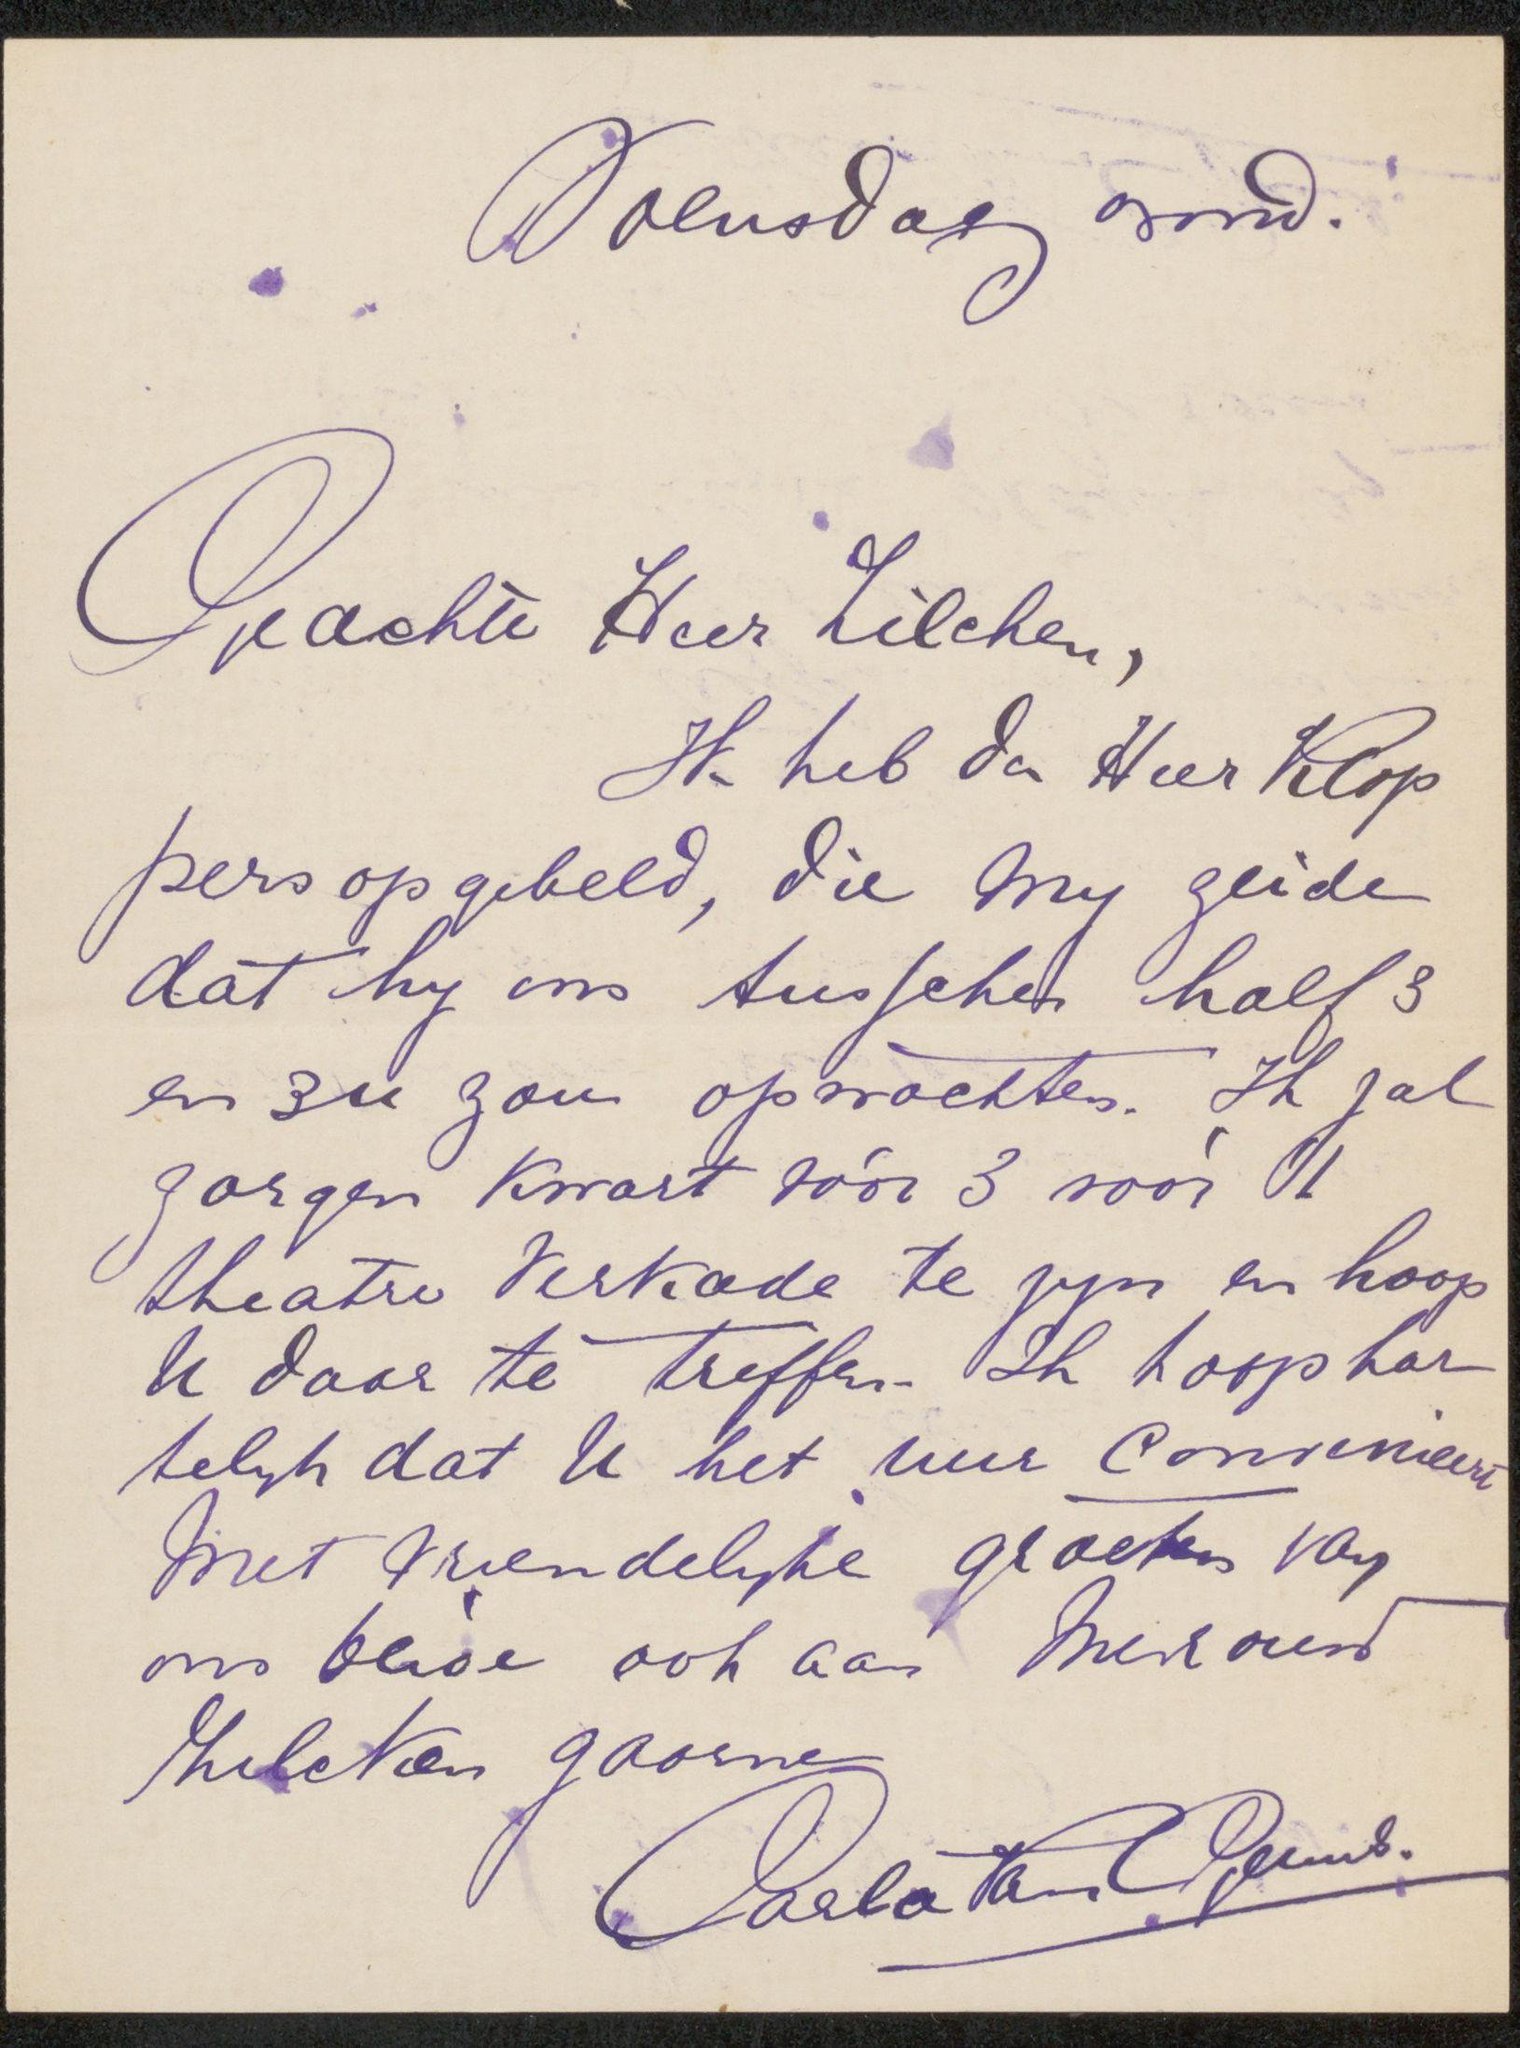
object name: letter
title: Brief aan Philip Zilcken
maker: carla van geuns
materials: ink, paper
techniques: pen, writing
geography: the hague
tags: draughtsman, philip zilcken, the hague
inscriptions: collector's mark: ‘RPK’